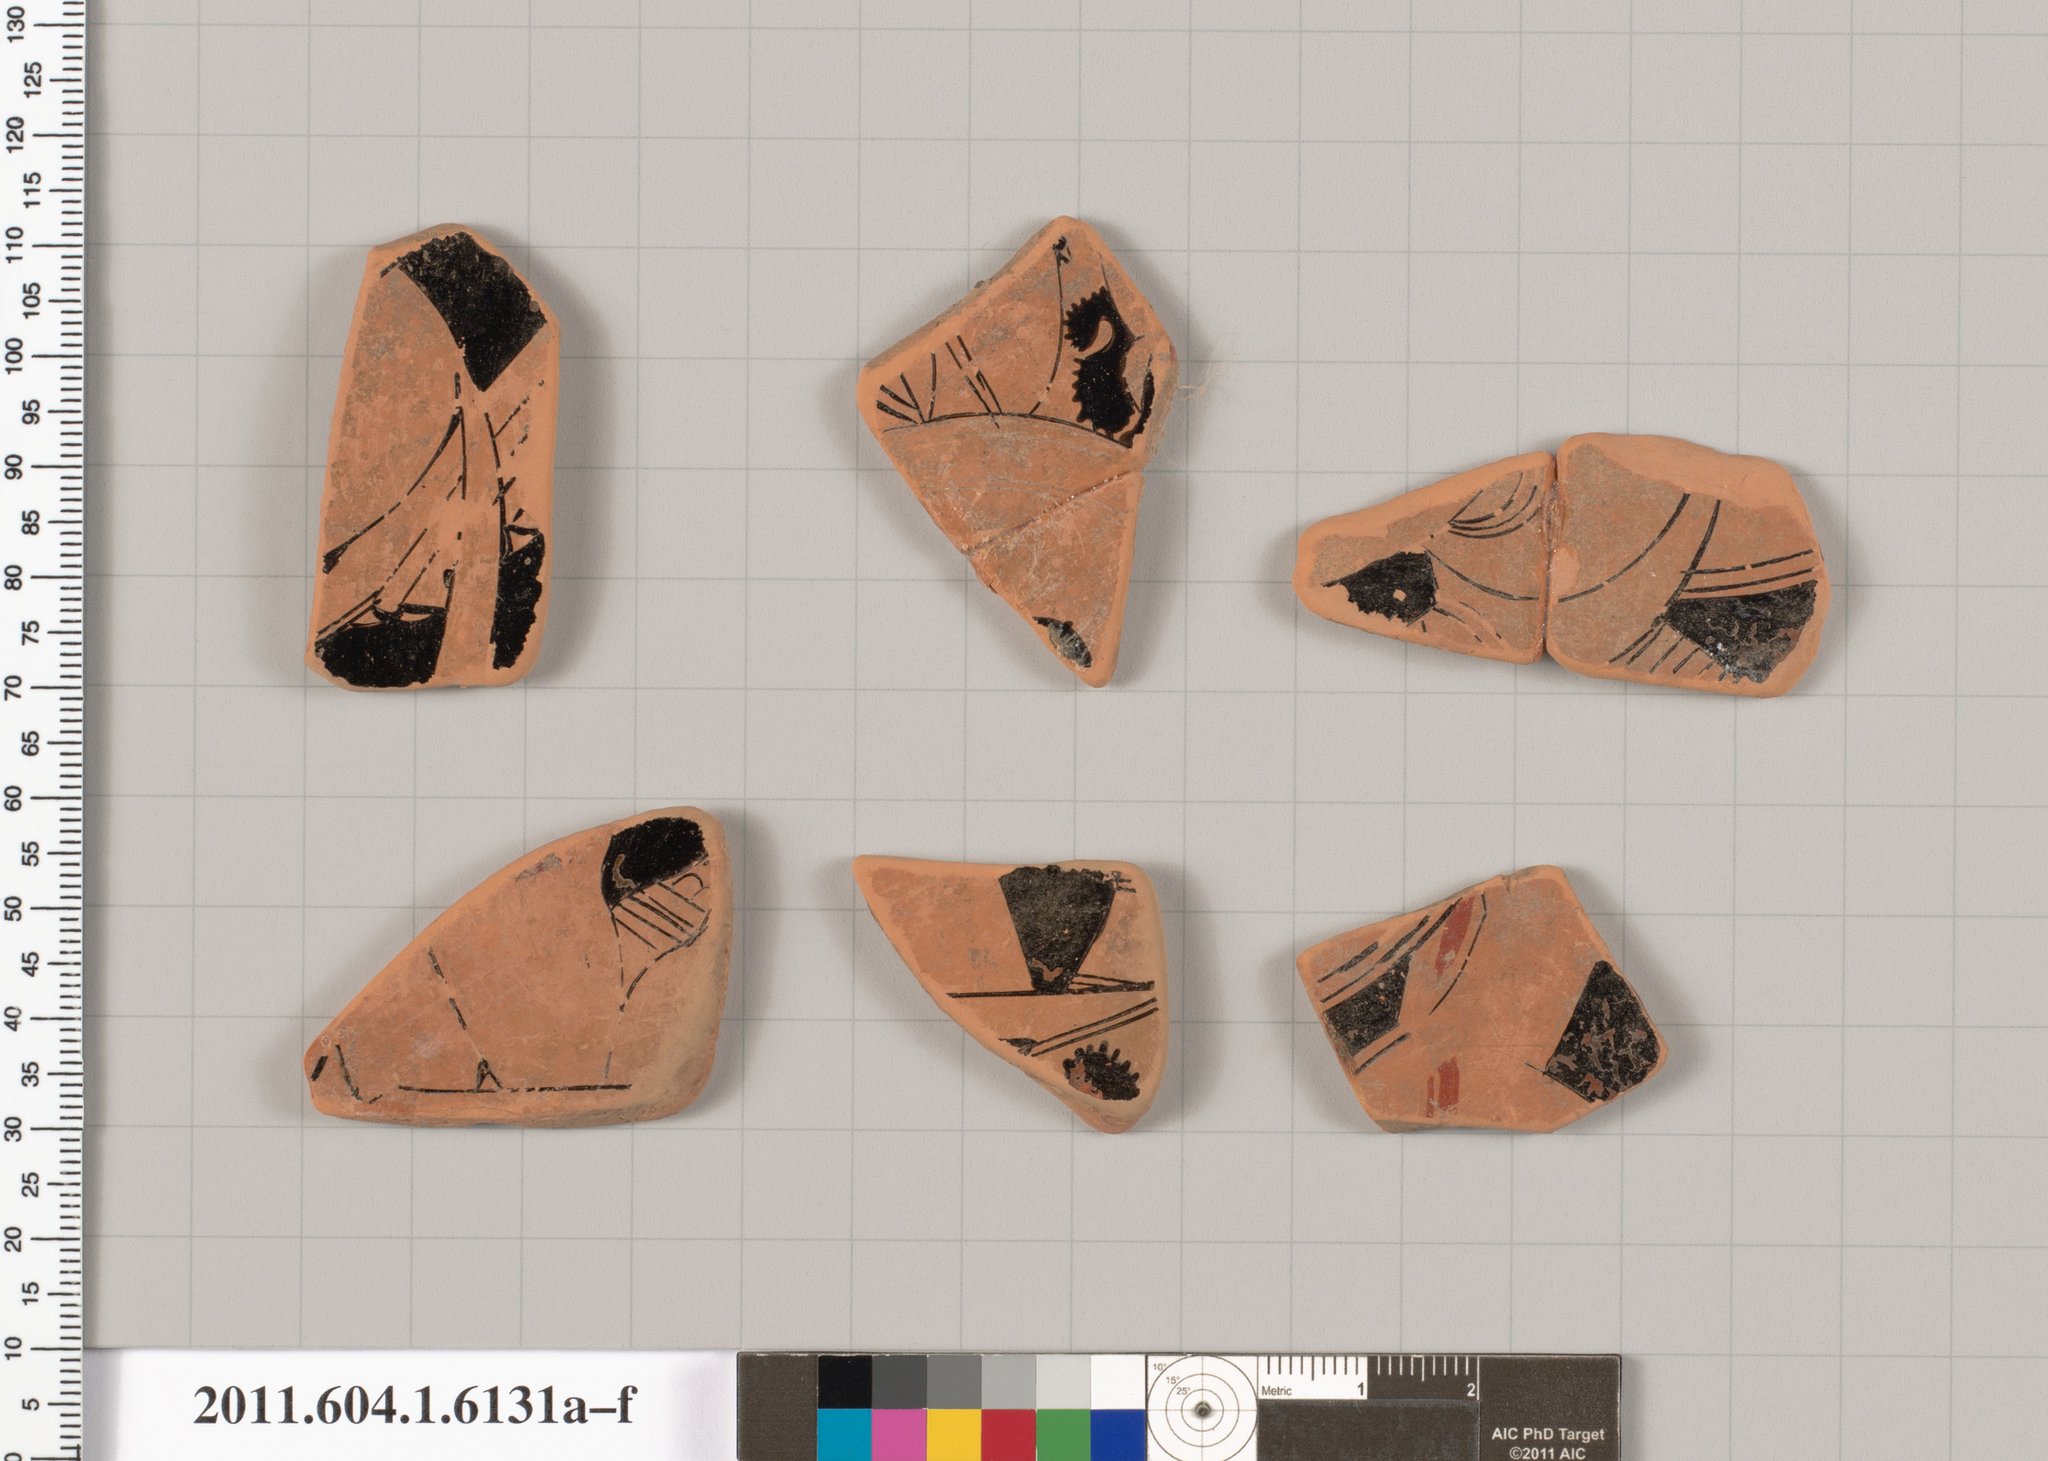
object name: kylix fragment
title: Terracotta fragments of a kylix (drinking cup)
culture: greek, attic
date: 520-500 BCE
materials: terracotta